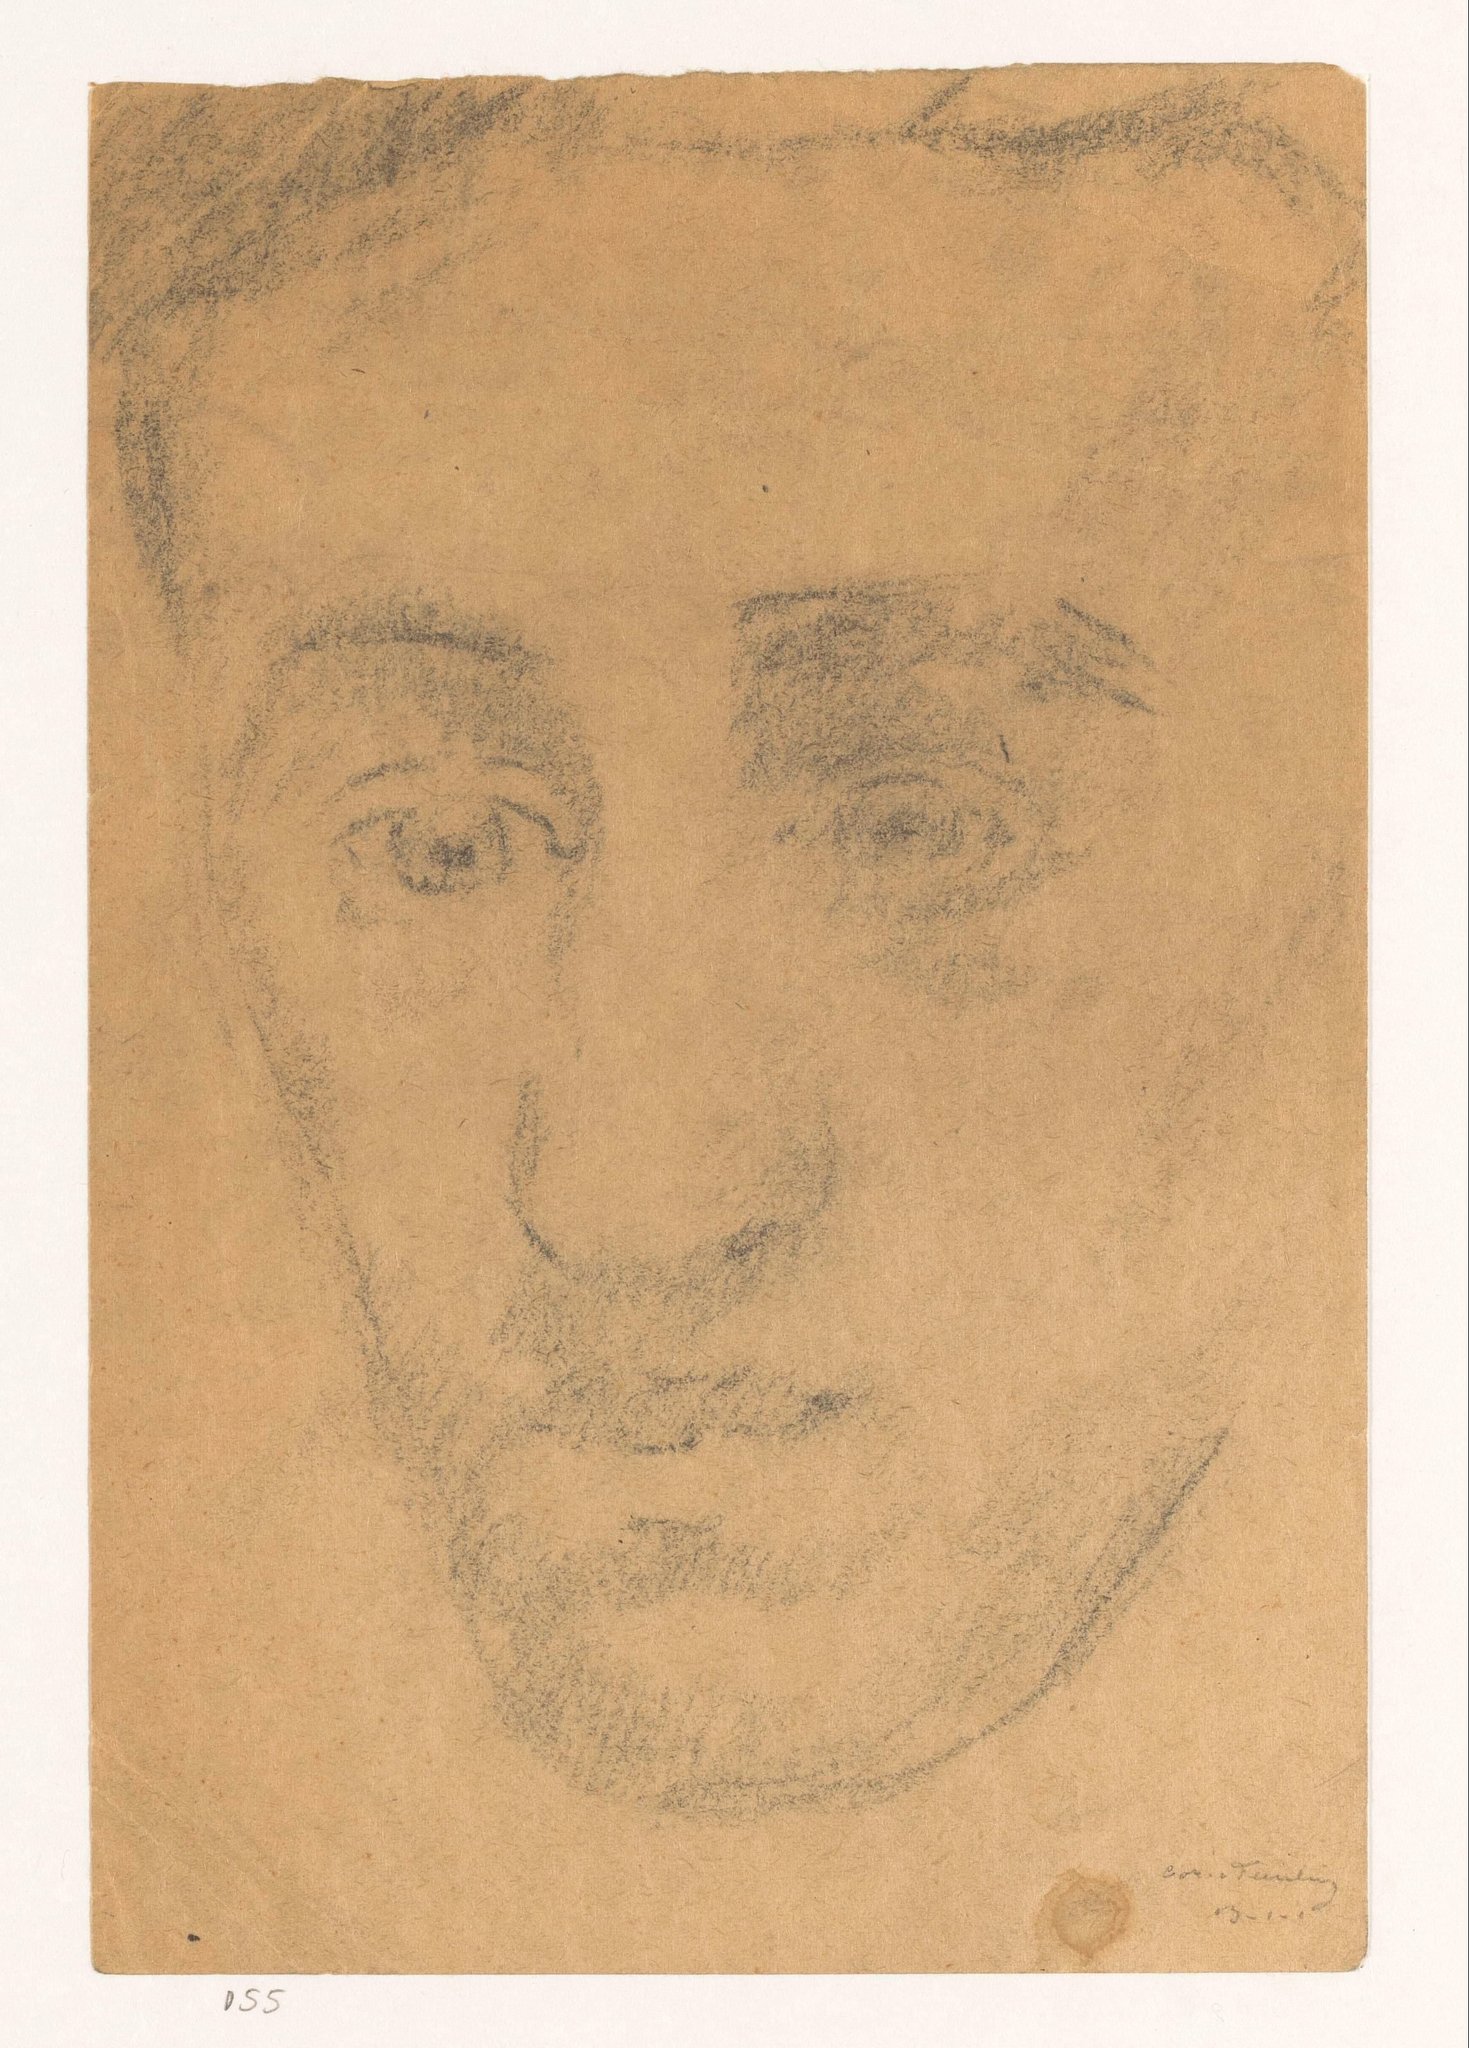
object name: drawing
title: Zelfportretten van Cor van Teeseling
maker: cor van teeseling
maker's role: draughtsman, sculptor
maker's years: 1915-1942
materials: chalk, paper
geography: weteringschans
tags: amsterdam, draughtsman, sculptor, cor van teeseling, historical persons, prisoner in cell or locked place, portrait, self-portrait of draughtsman, netherlands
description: Zelfportret van Cor van Teeseling en face: B-1-1. De boven- en rechterzijkant van het hoofd zijn weg.